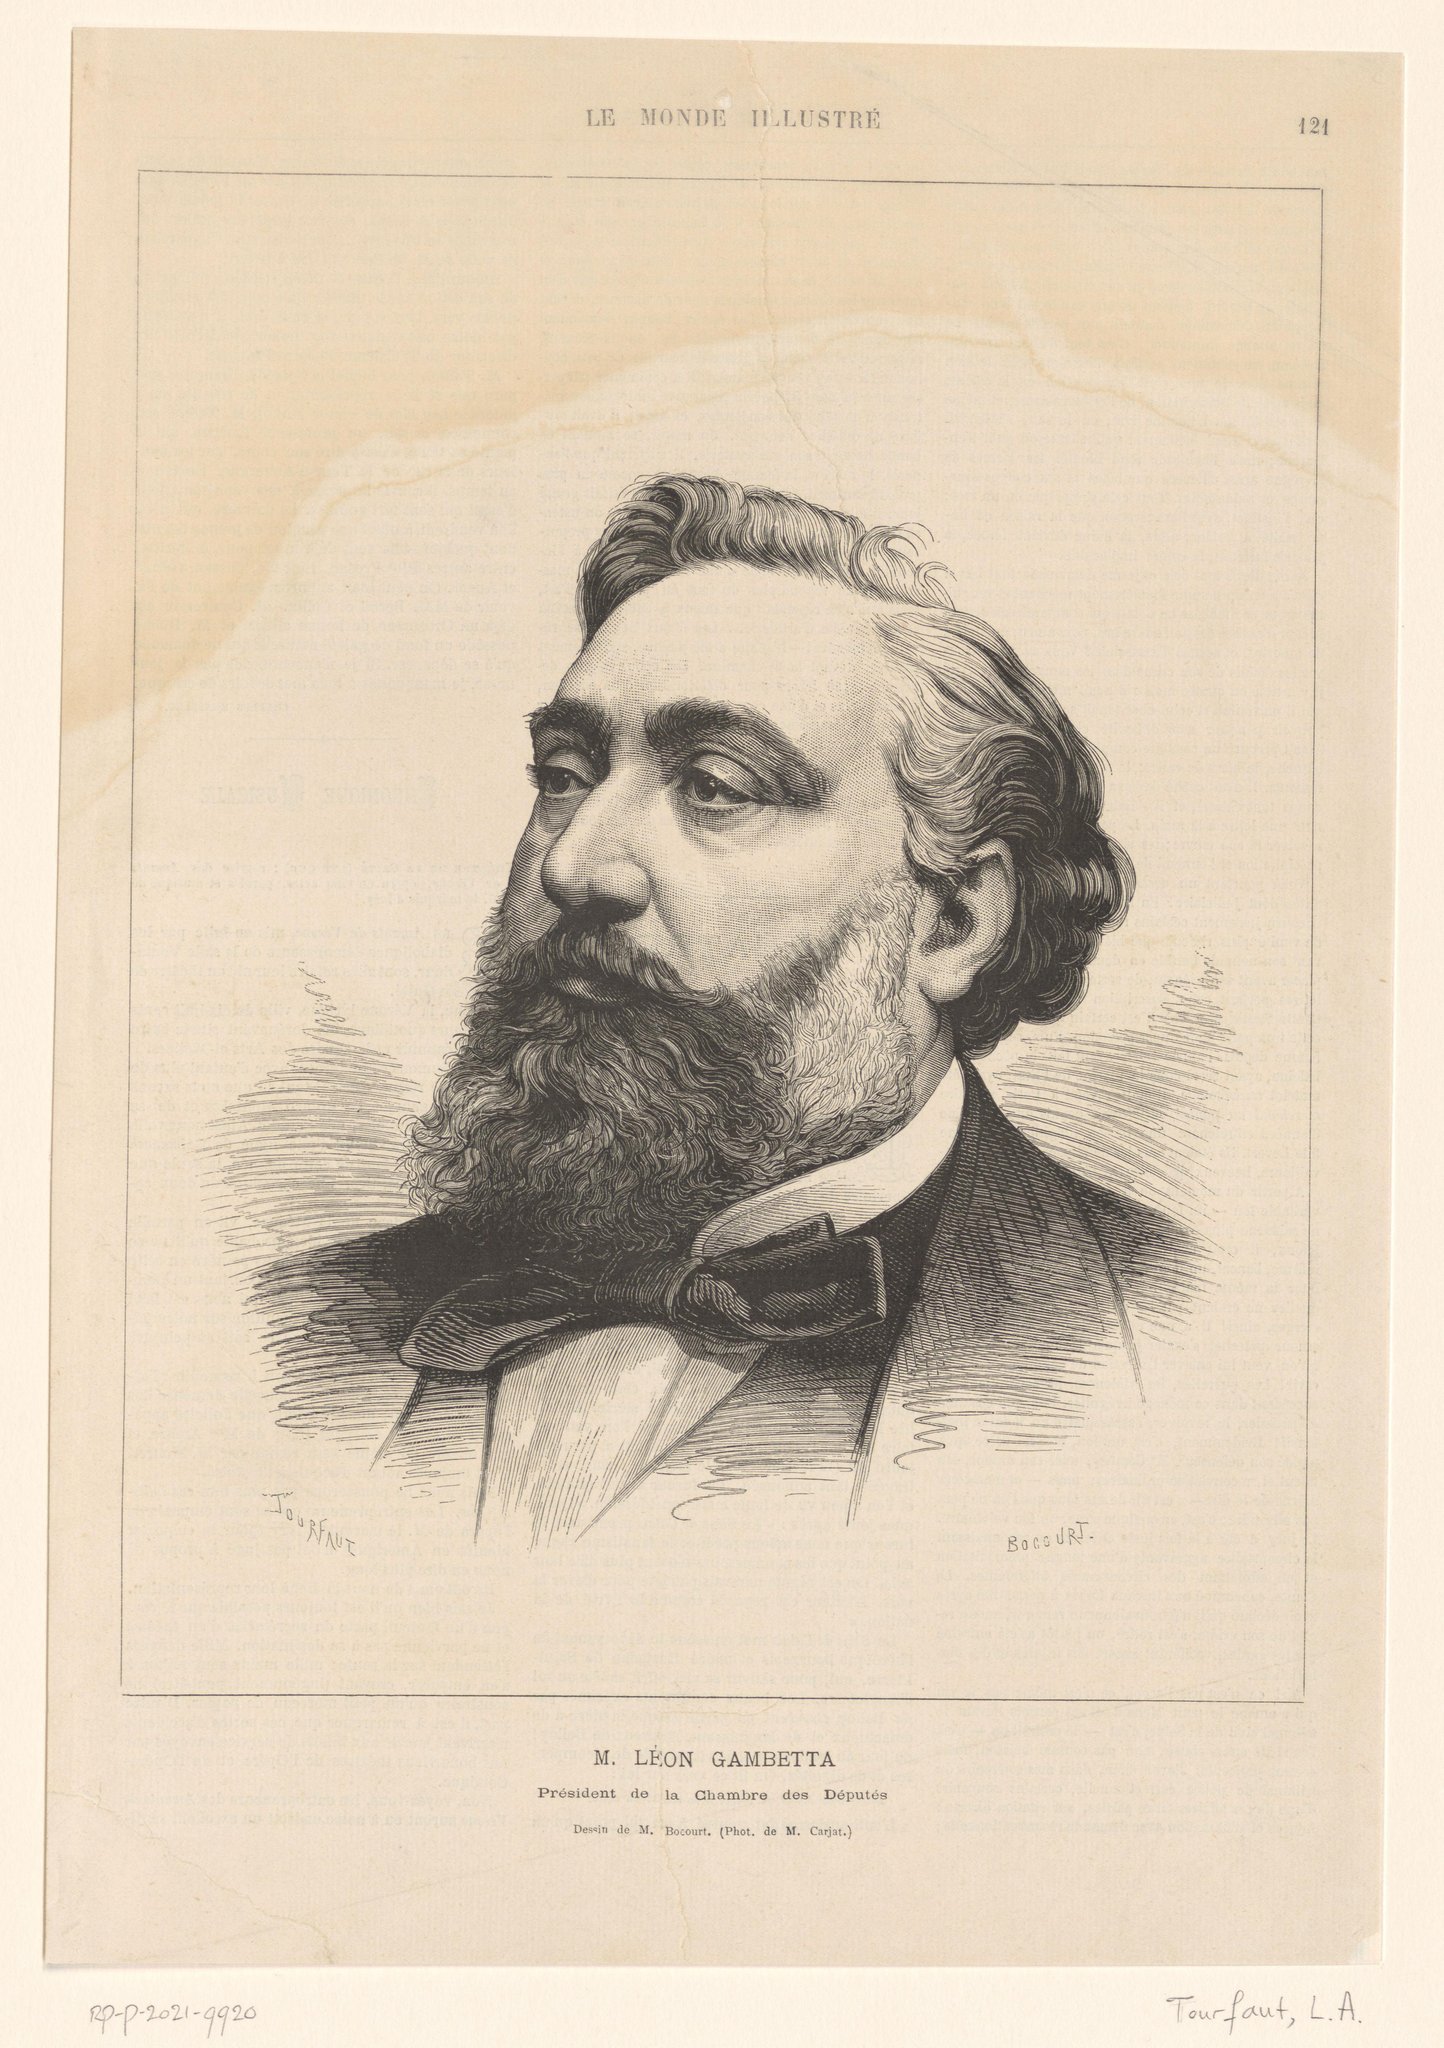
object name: print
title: Portret van Léon Gambetta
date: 1881-1882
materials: paper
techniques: letterpress printing, engraving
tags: historical persons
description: Prent waarschijnlijk uit: Le monde illustré, uitgegeven tussen 1857–1940.